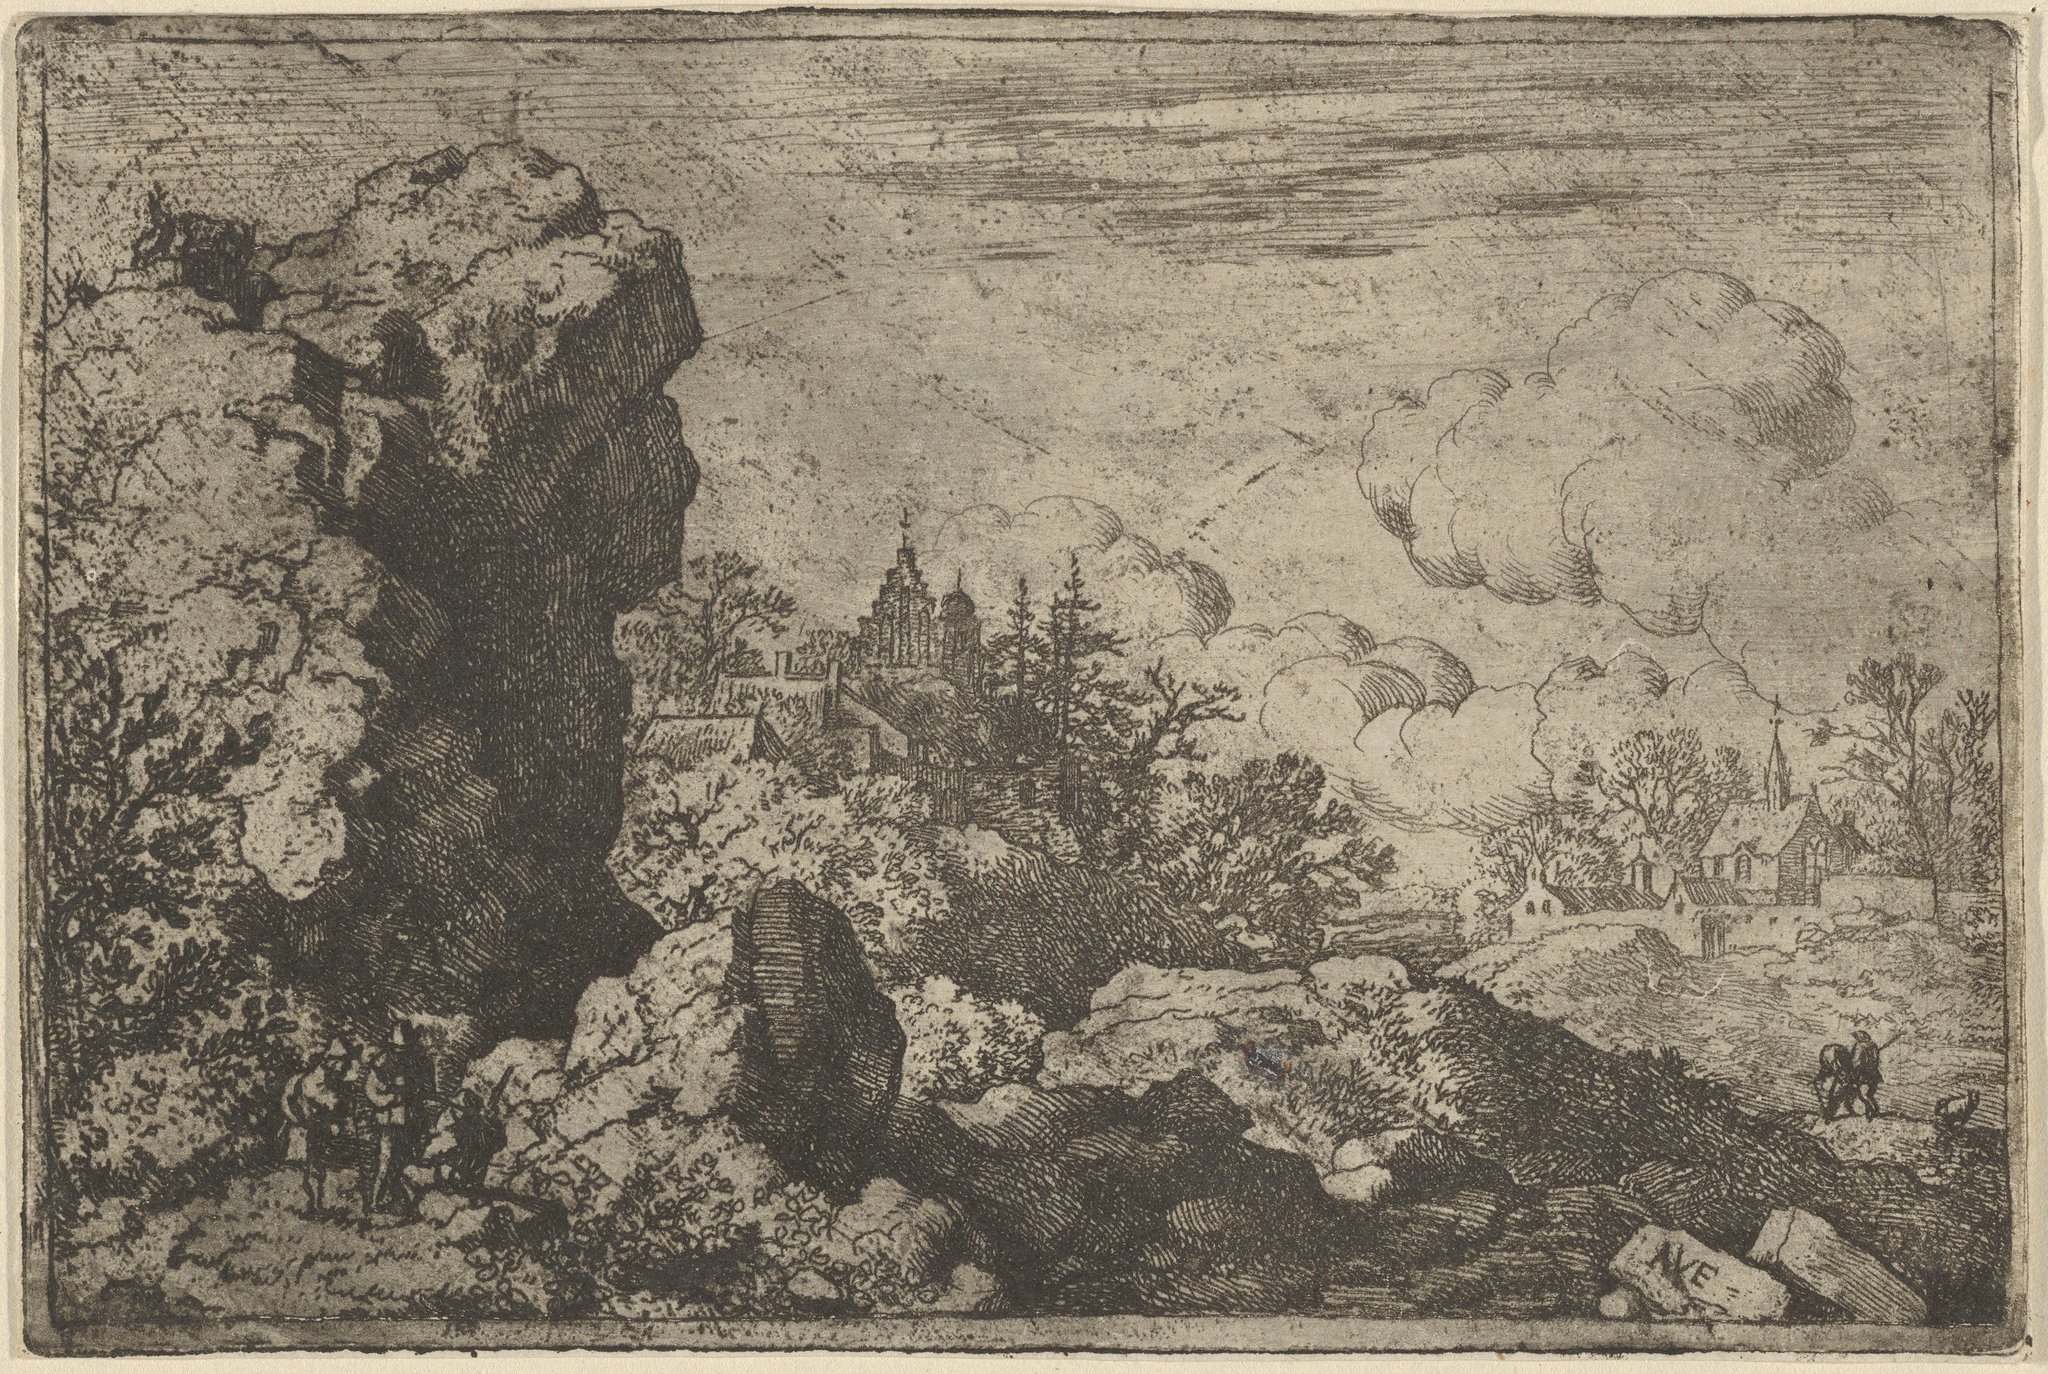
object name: print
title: The Three Travellers at the Foot of High Rock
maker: allart van everdingen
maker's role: artist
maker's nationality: dutch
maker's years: 1621-1675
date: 1621-1675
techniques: engraving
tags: human figures,buildings,trees